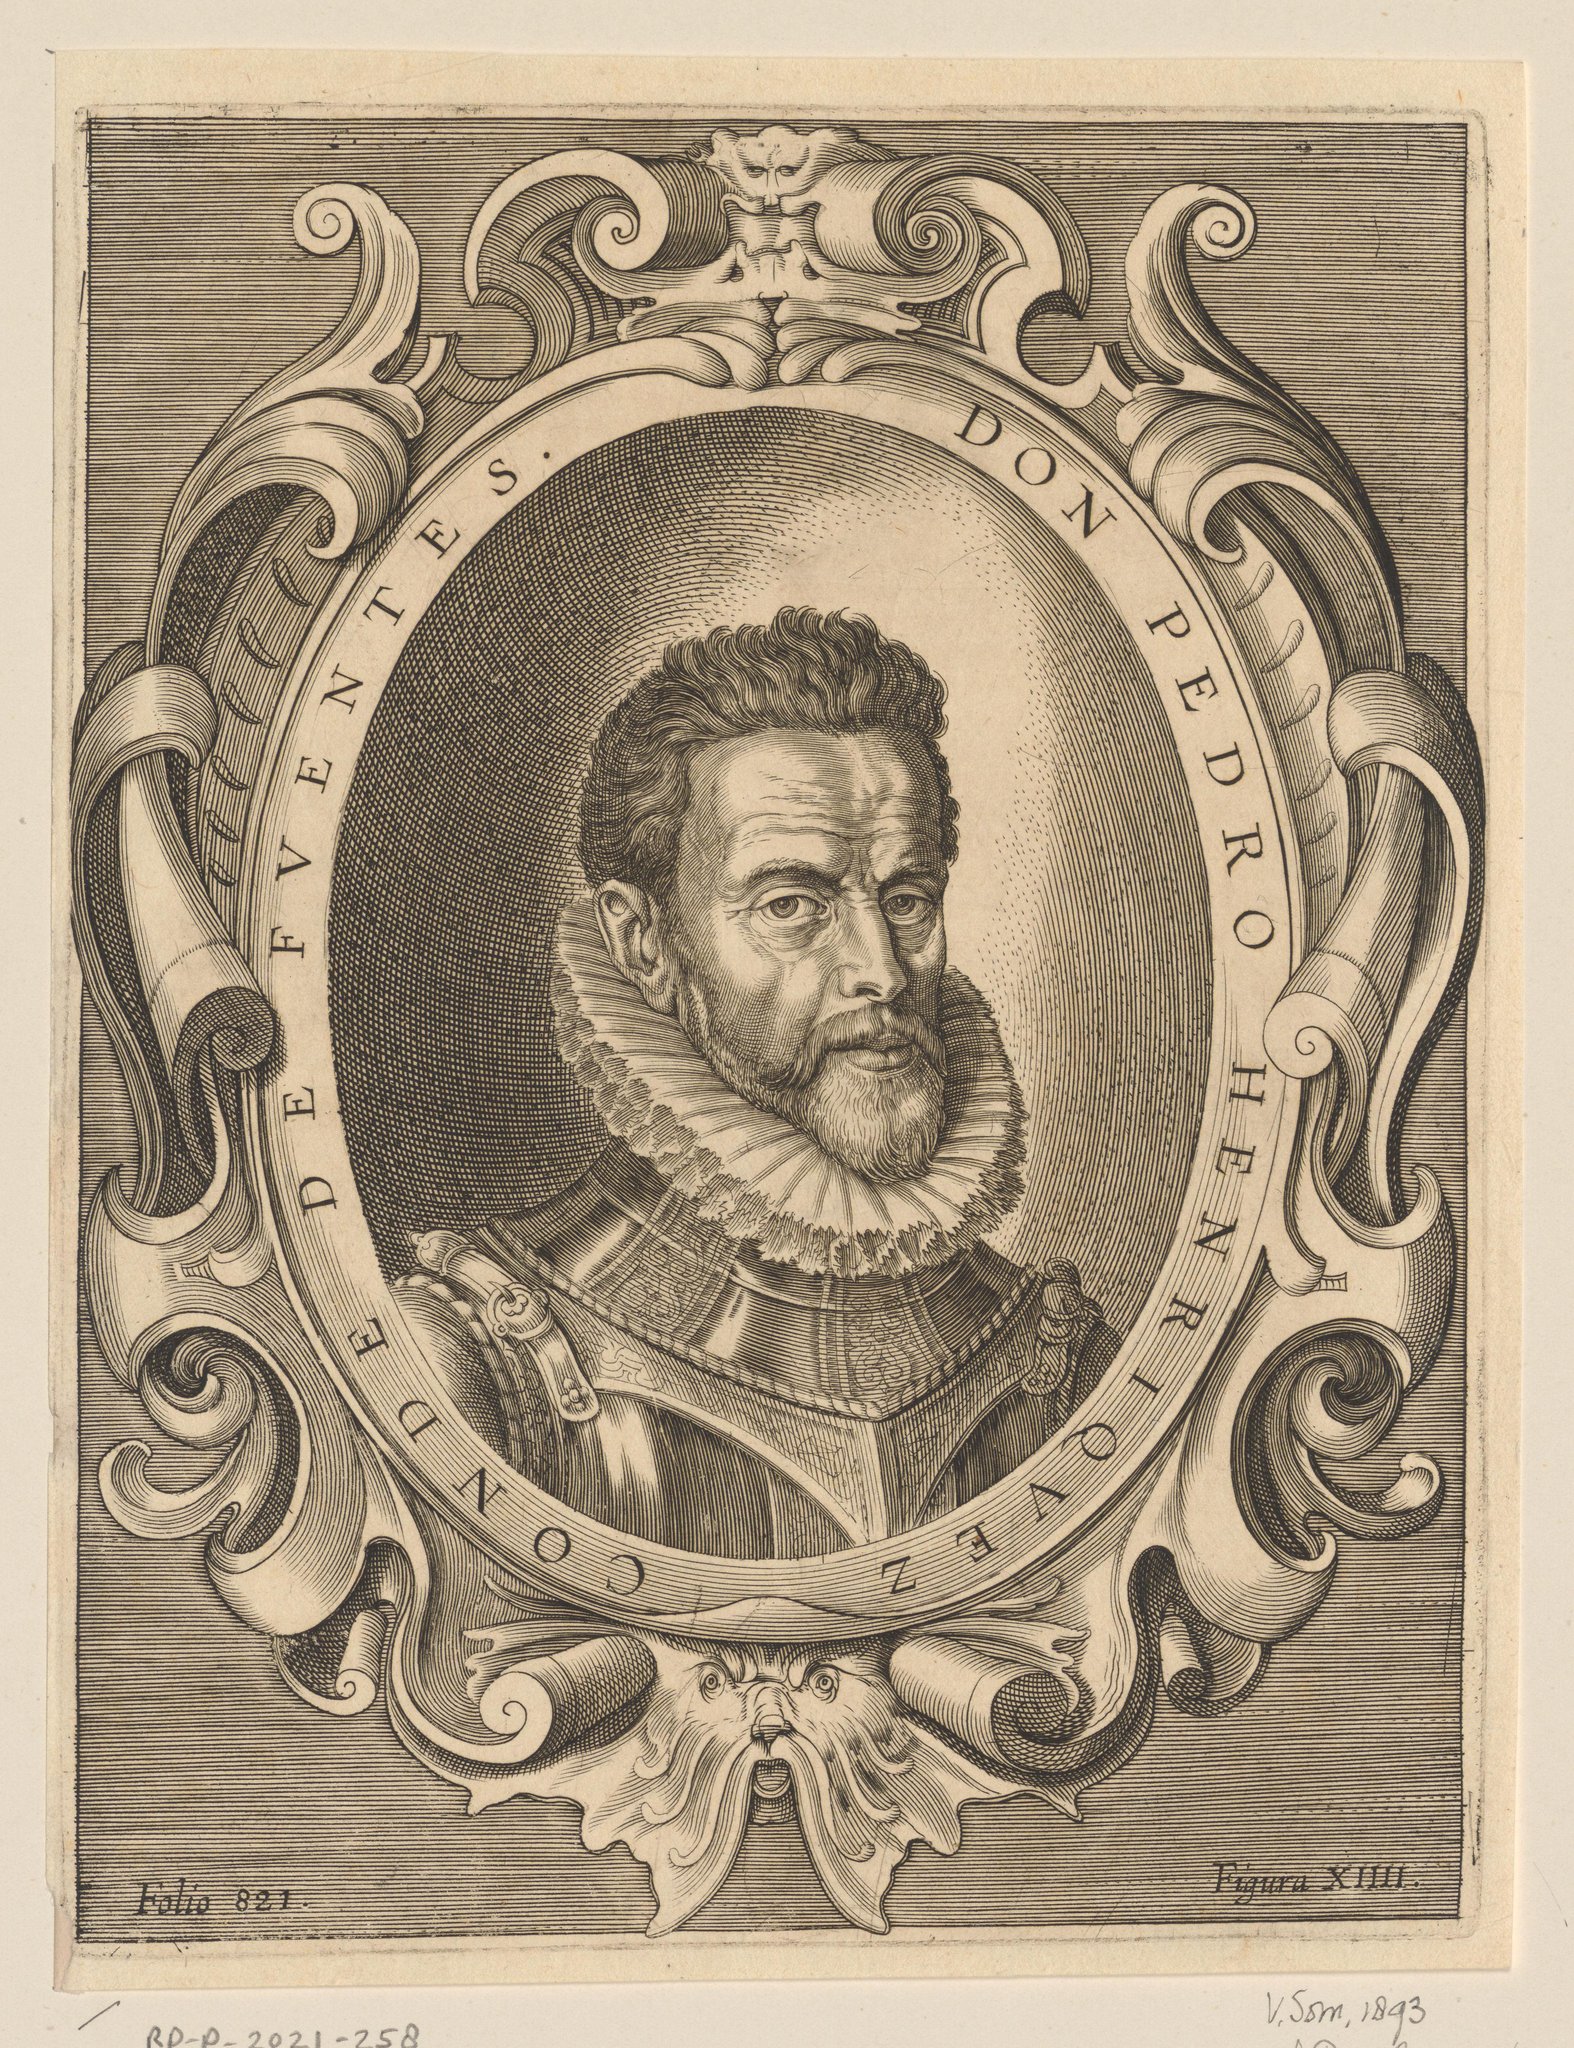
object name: print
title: Portretten van vorsten en andere illustere figuren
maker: niccolò nelli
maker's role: print maker, publisher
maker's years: 1535-1585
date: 1569-1620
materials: paper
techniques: engraving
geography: venice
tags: politician, pedro enríquez de acevedo (count of fuentes), rocaille ornament, commander-in-chief, general, marshal, armour, historical persons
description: Prent waarschijnlijk uit: Meerbeeck, Adriaan van. Chroniicke vande Gantsche Werelt (...). Antwerpen: Hieronymus Verdussen, 1620, p. 821. Prent ook gebruikt voor de serie 'Imagines Quorundam Principum et Illustrium Virorum', uitgegeven in Venetië in 1569, mogelijk in een eerdere staat zonder fol. 821.